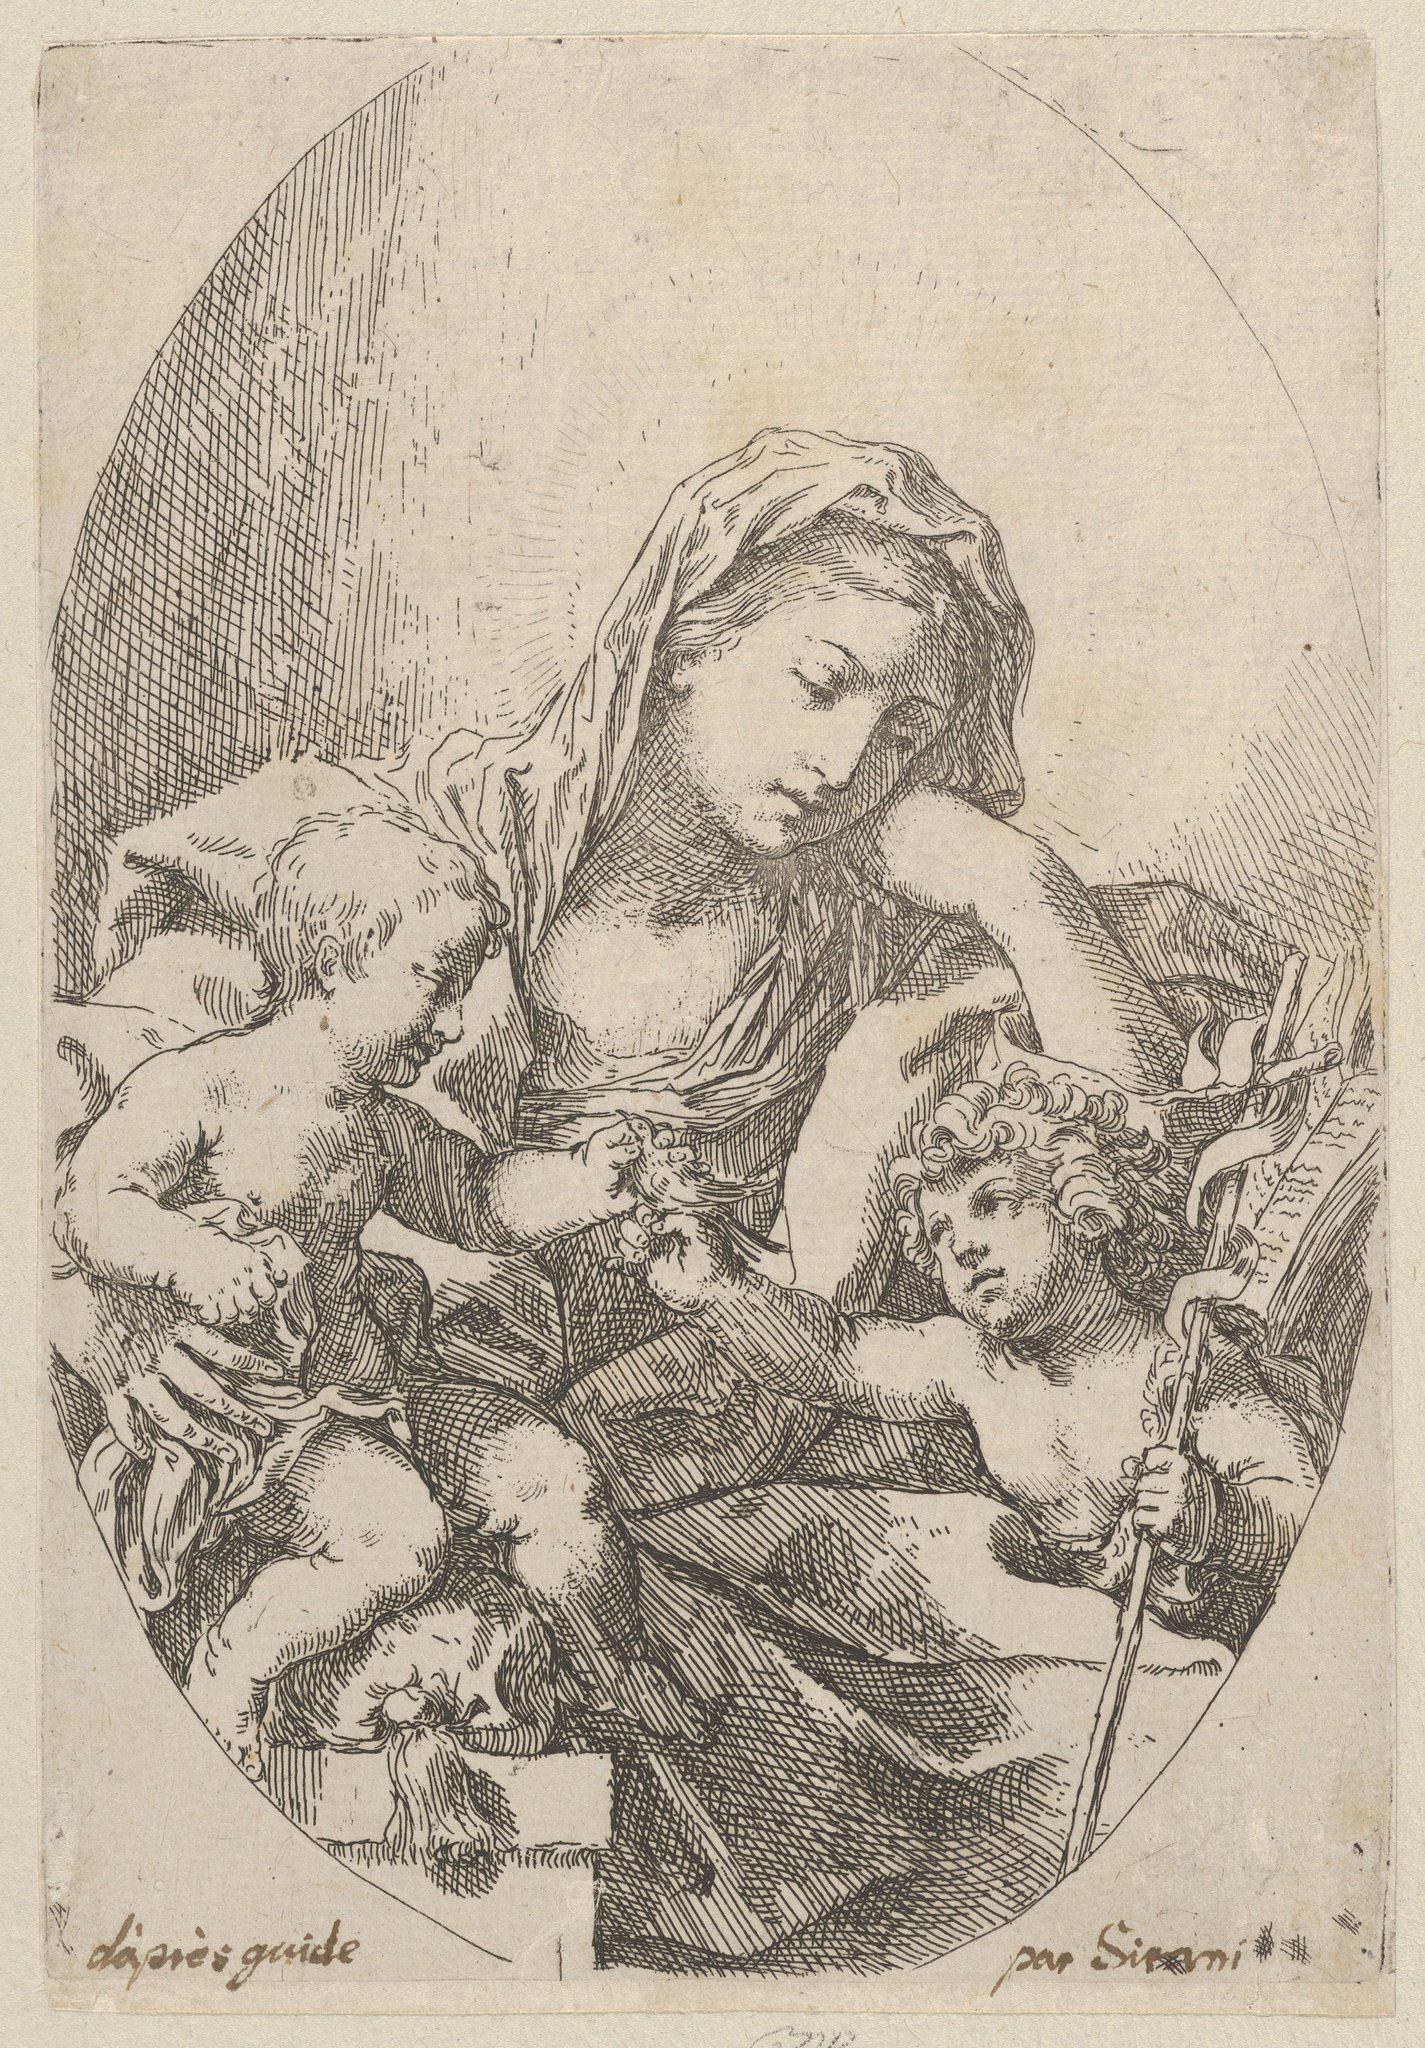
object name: print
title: The Virgin with the Christ Child and the young Saint John the Baptist holding a bird at right, an oval composition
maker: lorenzo loli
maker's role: artist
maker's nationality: italian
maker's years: 1607-1691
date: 1630-1680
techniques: etching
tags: christ,saint john the baptist,virgin mary